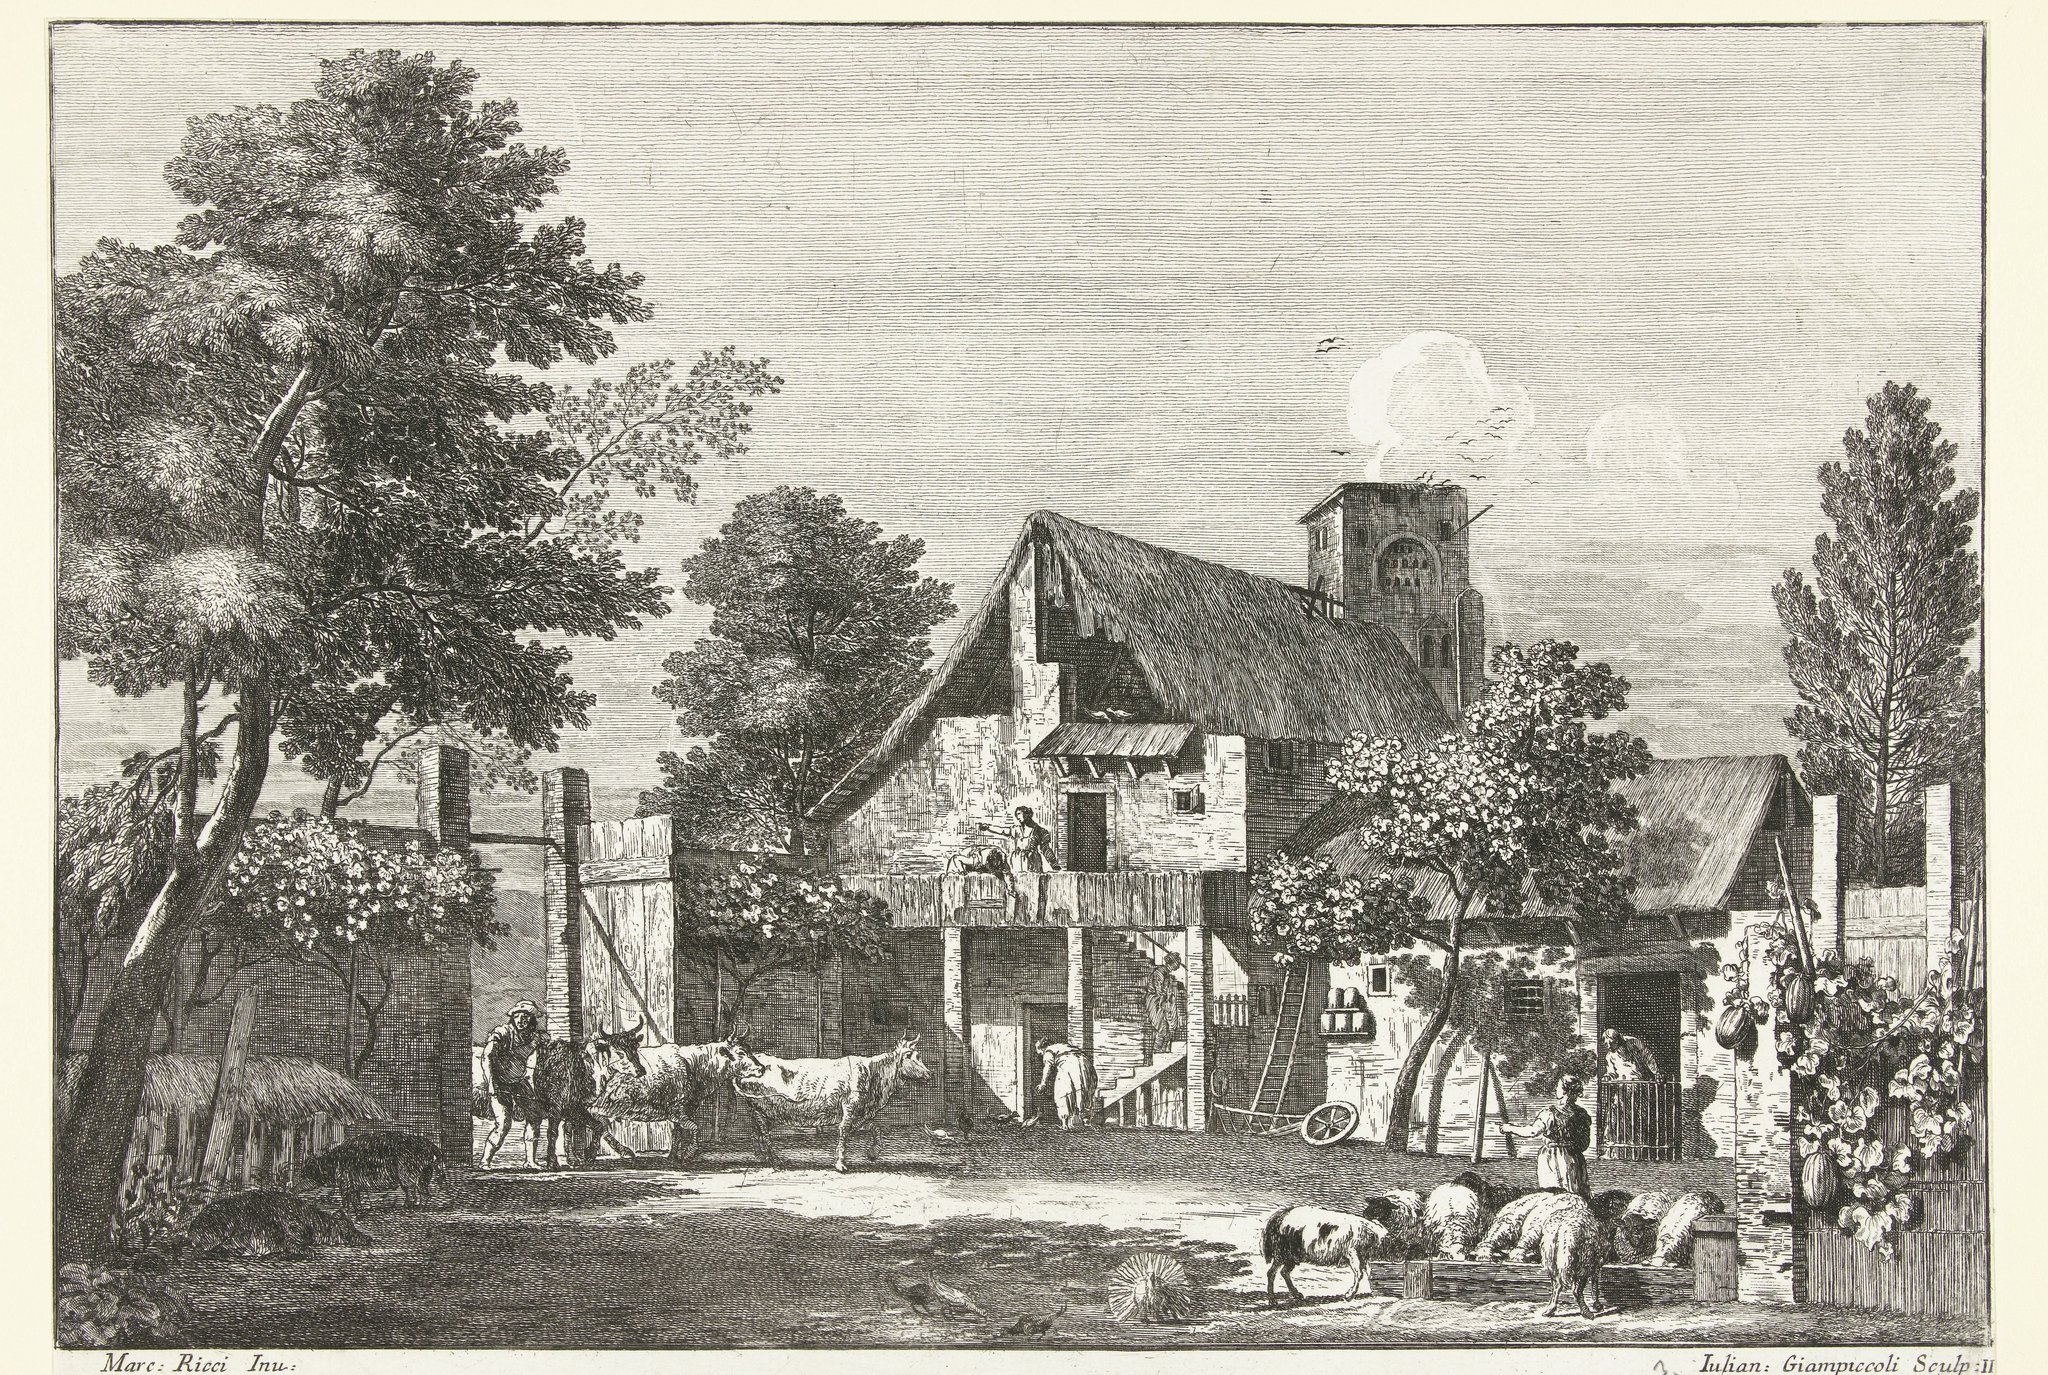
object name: print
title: Italiaanse landschappen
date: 1739-1740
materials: paper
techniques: etching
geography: venice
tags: cattle, façade of inner court, farm or solitary house in landscape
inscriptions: collector's mark: Lugt 2228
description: Prent uit tweede serie van negentien prenten met achttien Italiaanse landschappen naar ontwerp van Marco Ricci en titelprent (zie RP-P-1952-1). Tweede serie is opgedragen aan Antonio Maria Zanetti. De serie in de collectie van het RMA is gedrukt in de eerste staat voor vermelding van de uitgever Teodoro Viero. Het serienummer 3 is van het blad afgesneden.